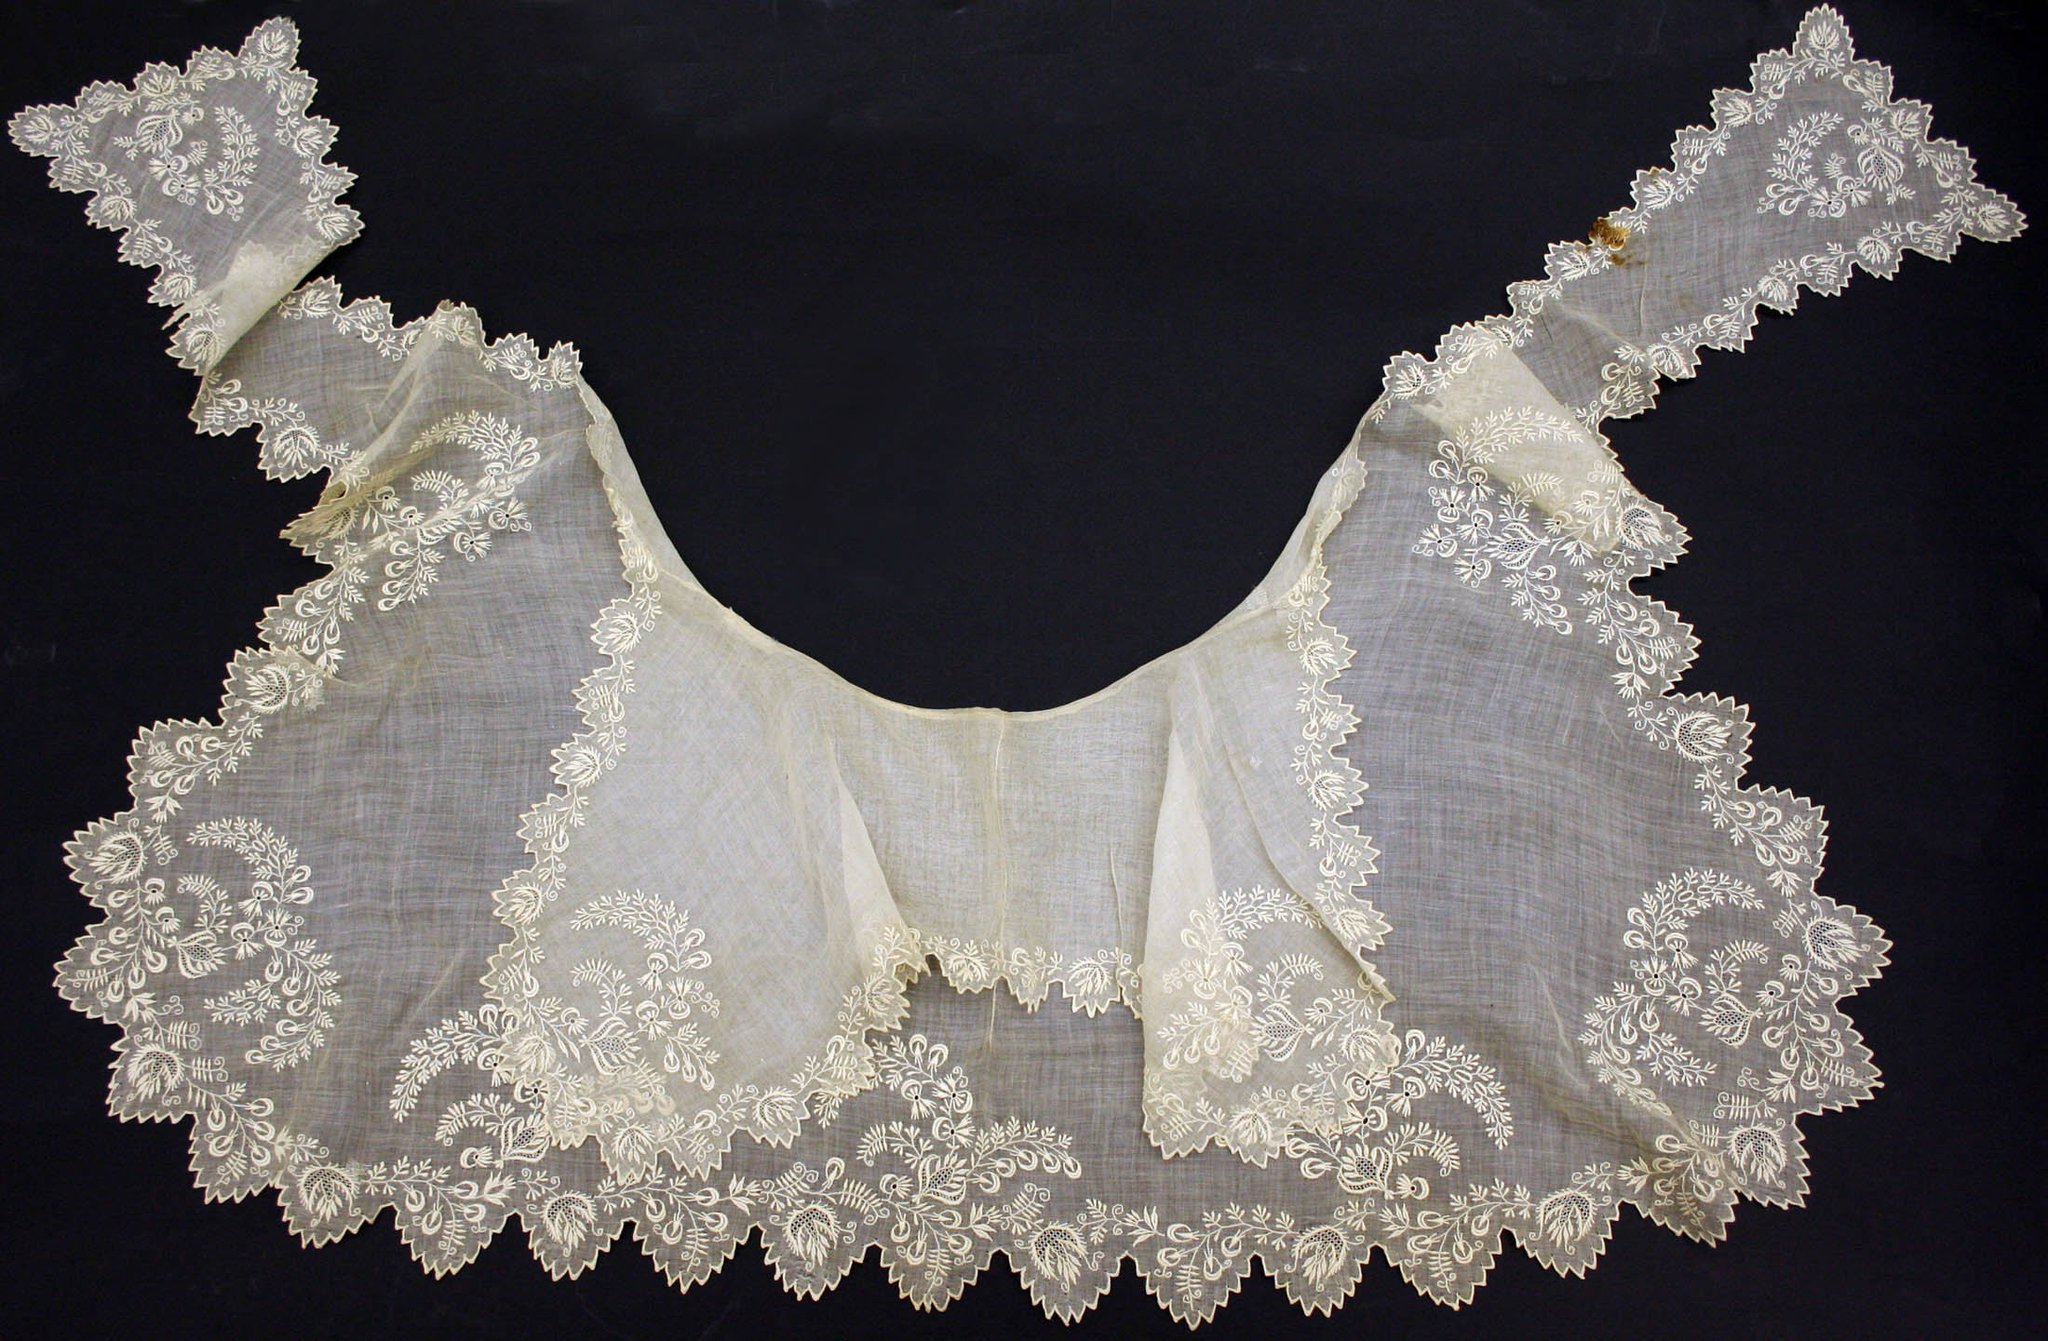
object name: double collar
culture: french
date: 1830-1839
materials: cotton